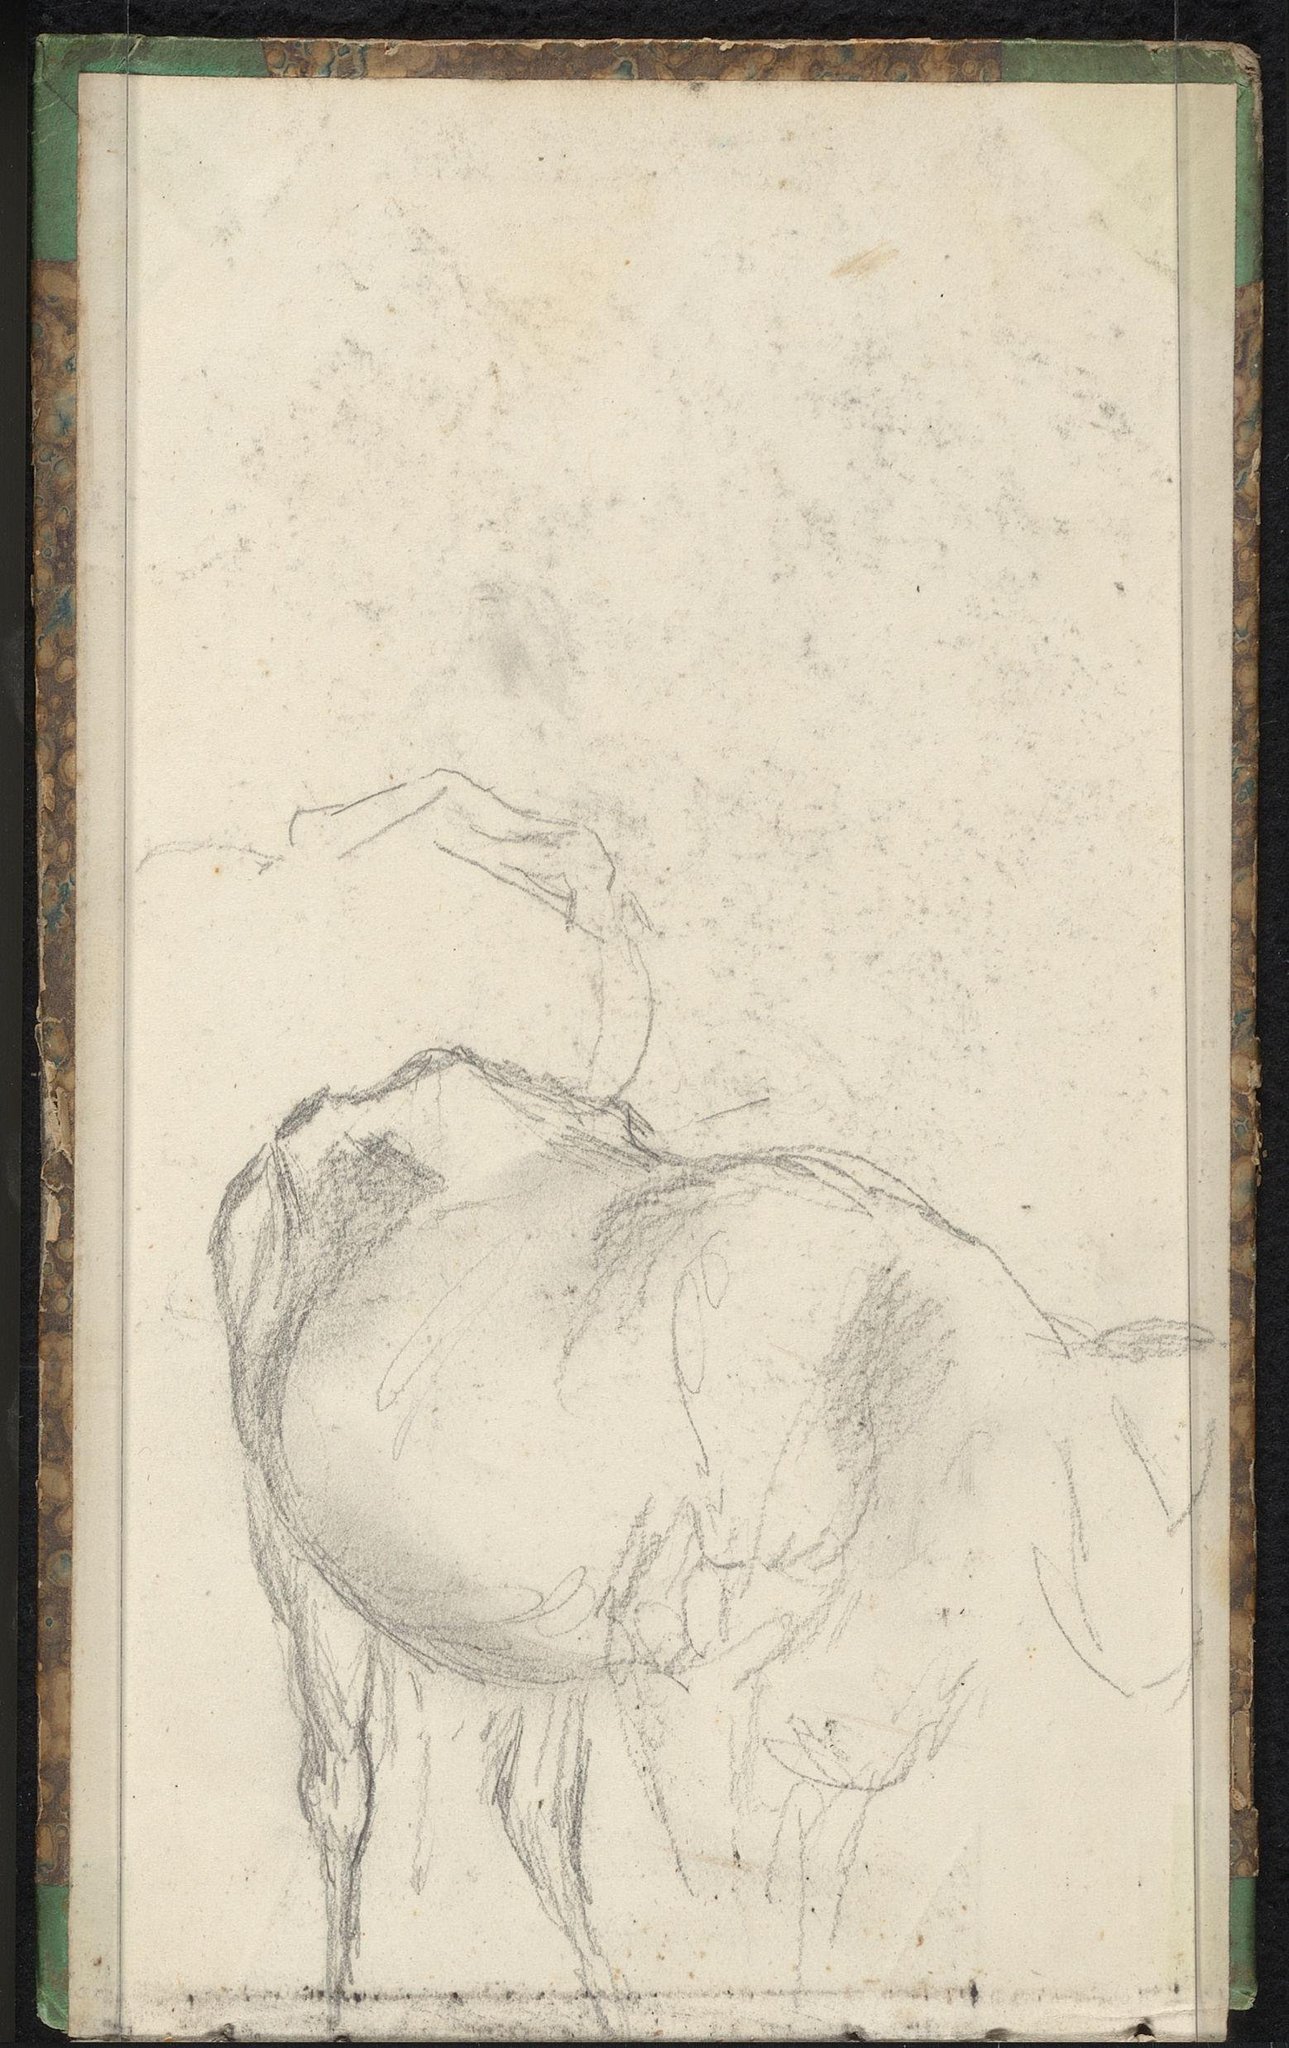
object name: endleaf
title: Rund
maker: jan bedijs tom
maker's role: draughtsman, painter, print maker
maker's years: 1813-1894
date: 1828-1894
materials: paper, pencil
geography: the hague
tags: bovine cattle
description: Achterste schutblad uit een schetsboek met 50 bladen.